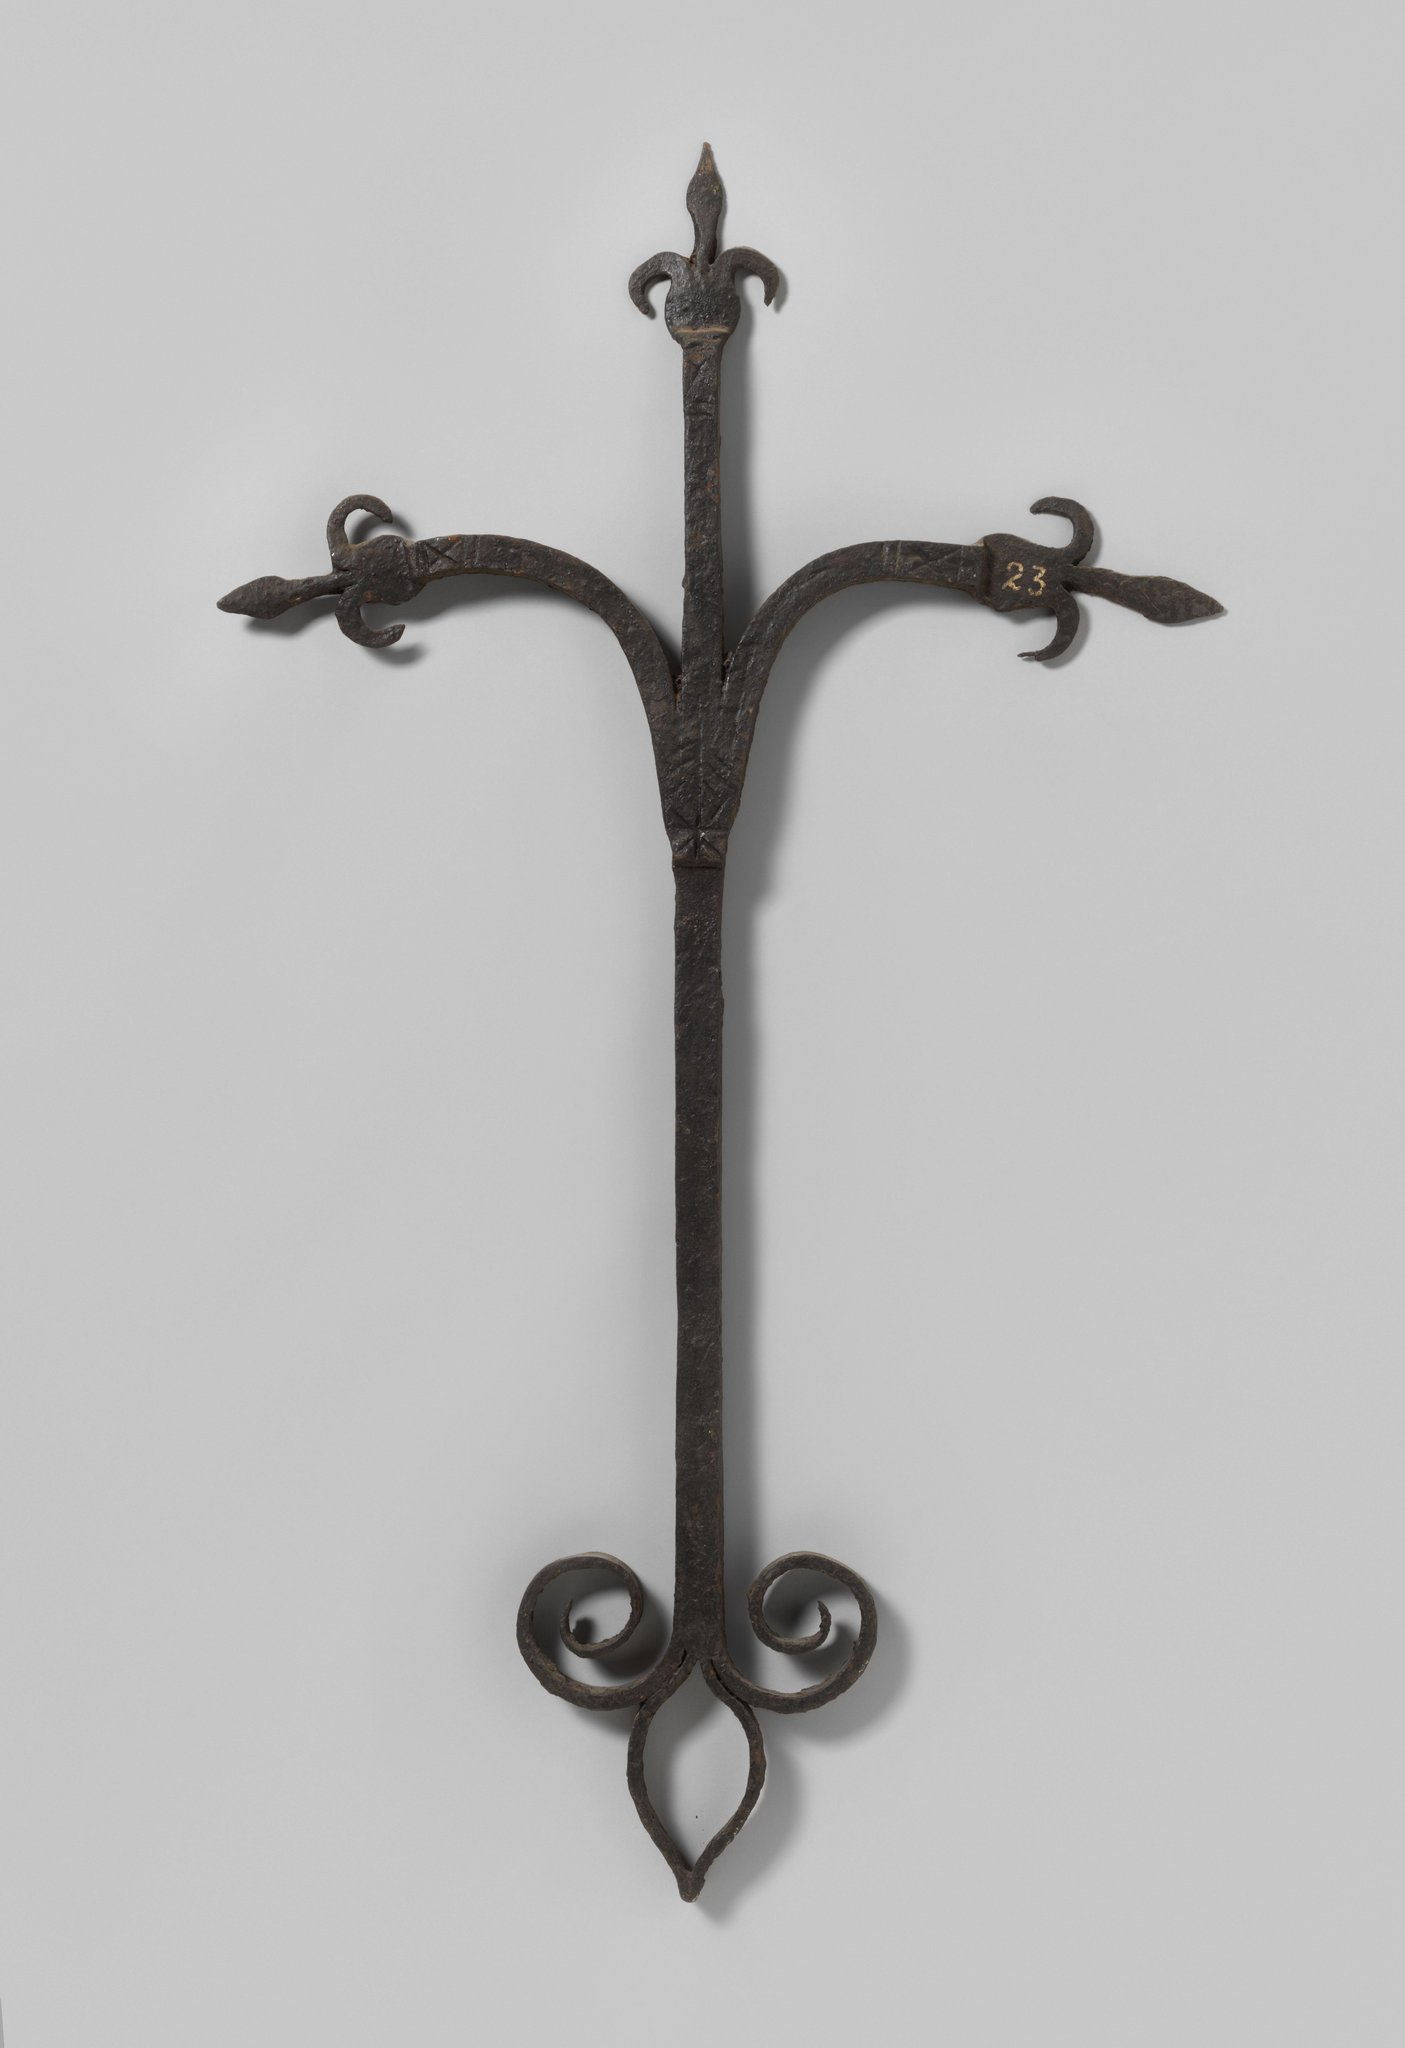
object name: anchor tie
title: Schieter van een muuranker van een huis te Arnhem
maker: Anonymous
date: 1400-1950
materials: iron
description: Smeedijzeren schieter van een muuranker van een huis te Arnhem.